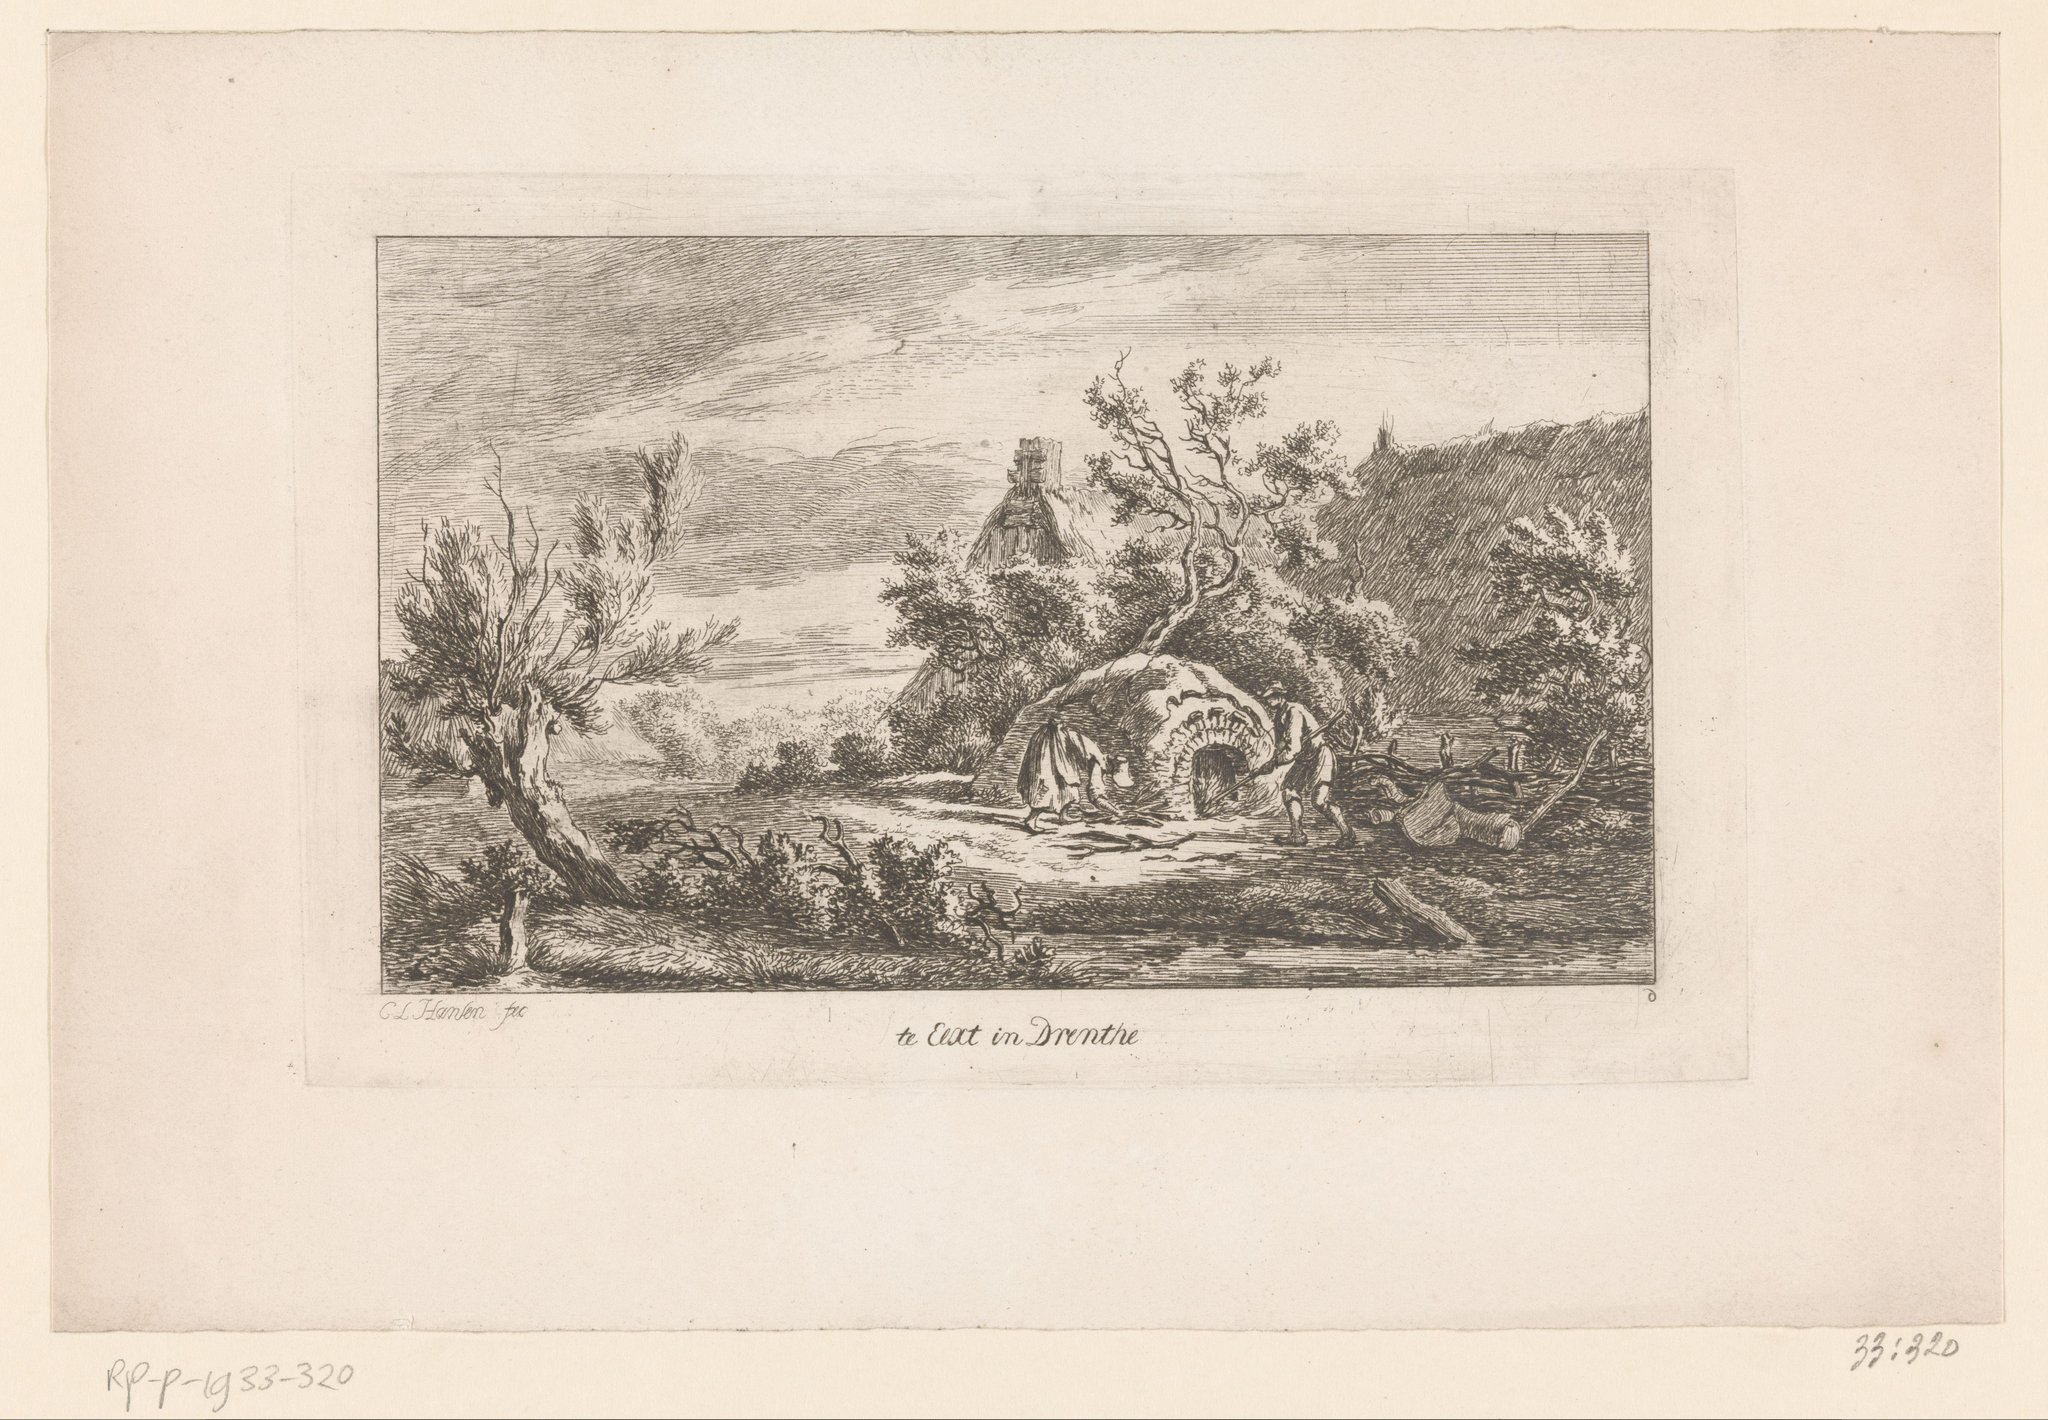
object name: print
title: Te Eext in Drenthe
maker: carel lodewijk hansen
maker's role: draughtsman, painter, print maker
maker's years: 1765-1840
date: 1775-1840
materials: paper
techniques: etching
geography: netherlands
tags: farm or solitary house in landscape, oven ~ kitchen - cc - in the open air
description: Onderdeel van een serie landschappen, voornamelijk in Drenthe, rechtsonder gemerkt: a-f. Deze prent is gemerkt: d.